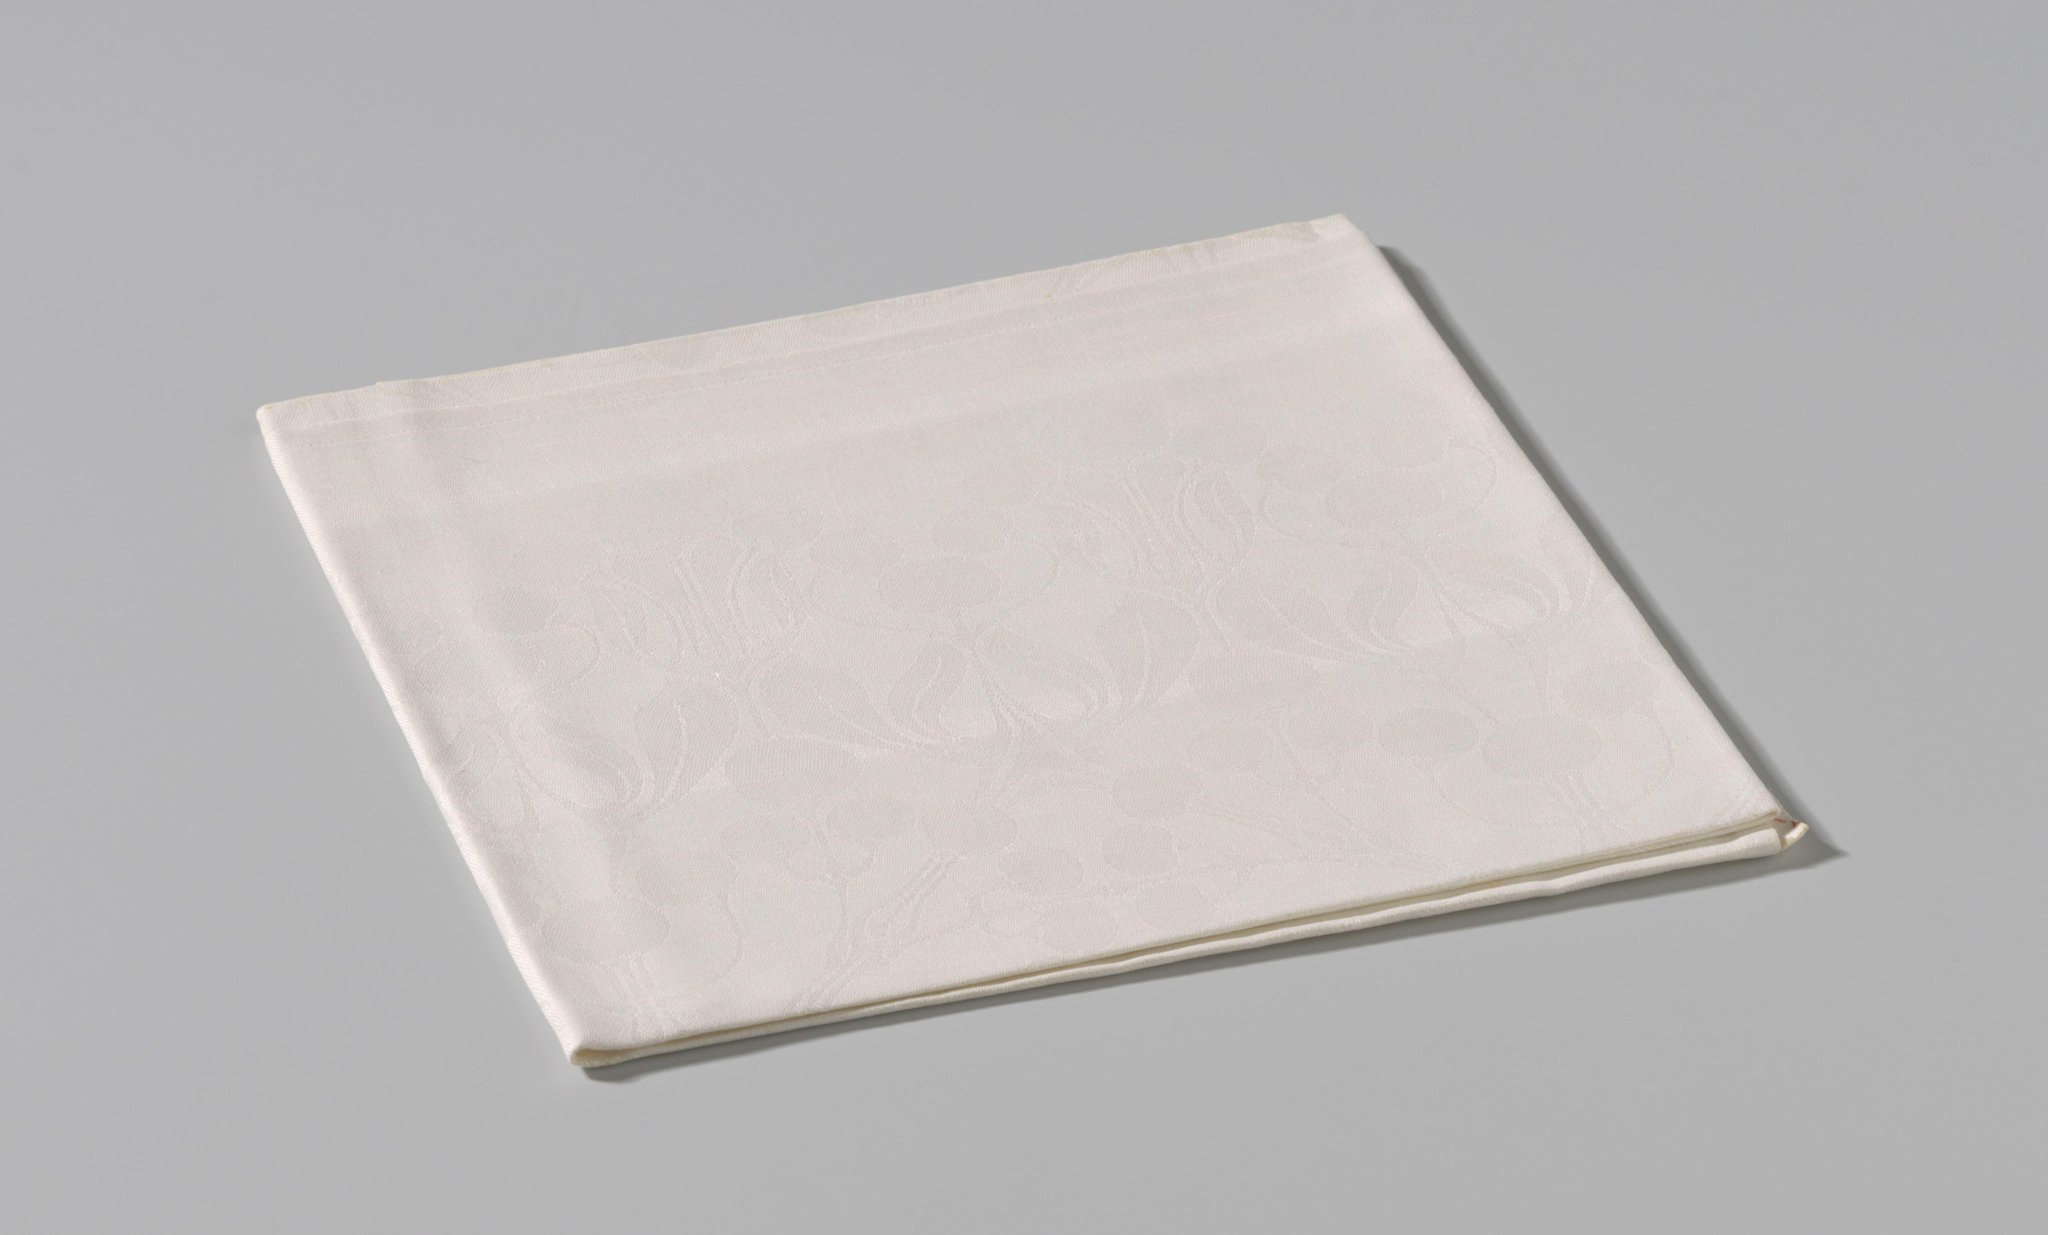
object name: napkin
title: Servet van linnendamast met kersen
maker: chris lebeau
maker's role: draughtsman, print maker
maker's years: 1878-1945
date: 1900-1925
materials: linen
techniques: damask, weave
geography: eindhoven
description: Servet van linnendamast met kersen (dessin 600 van Chris Lebeau). Het servet hoort bij vijf servetten (BK-1971-62-A t/m BK-1971-62-F) en een tafellaken (BK-1971-61).